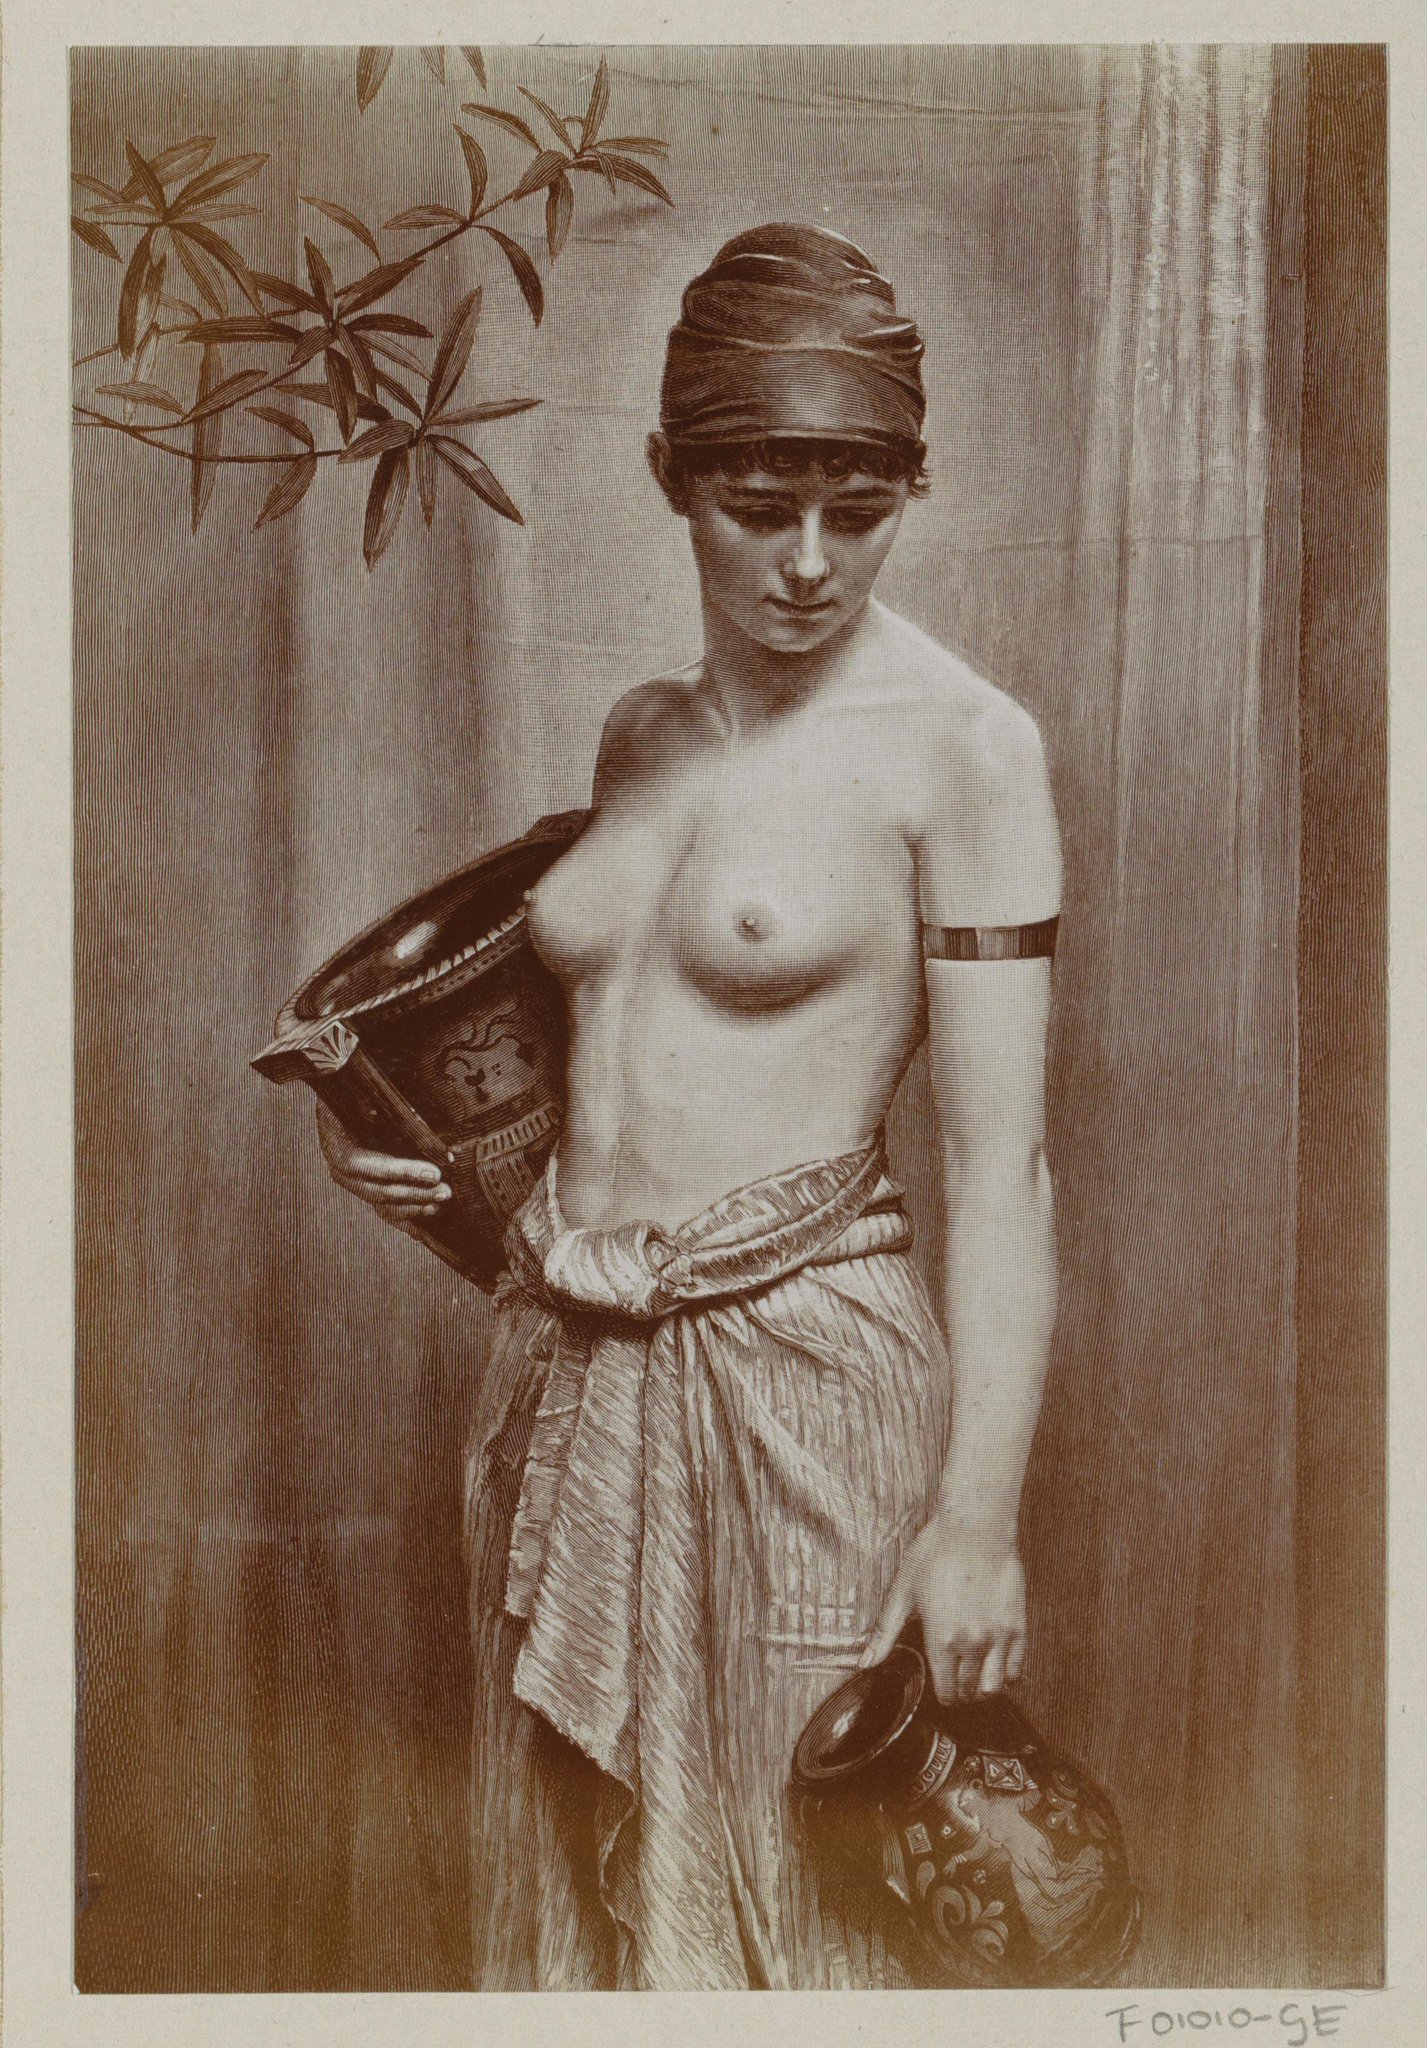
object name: reproduction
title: Fotoreproductie van (vermoedelijk) een gravure van een Griekse slavin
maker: f. feldweg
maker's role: print maker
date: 1900-1910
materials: photographic support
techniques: gelatin silver print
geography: berlin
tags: historical persons - bb - woman, slavery; serfs and enslaved persons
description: Onderdeel van Familiealbum met onder meer foto's van Wijnhandel Kraaij & Co. Bordeaux-Amsterdam.